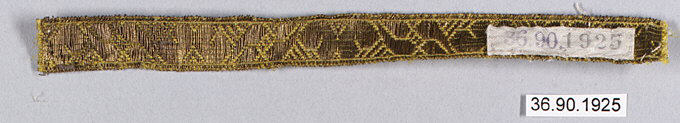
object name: galloon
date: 1801-1900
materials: metal thread, silk